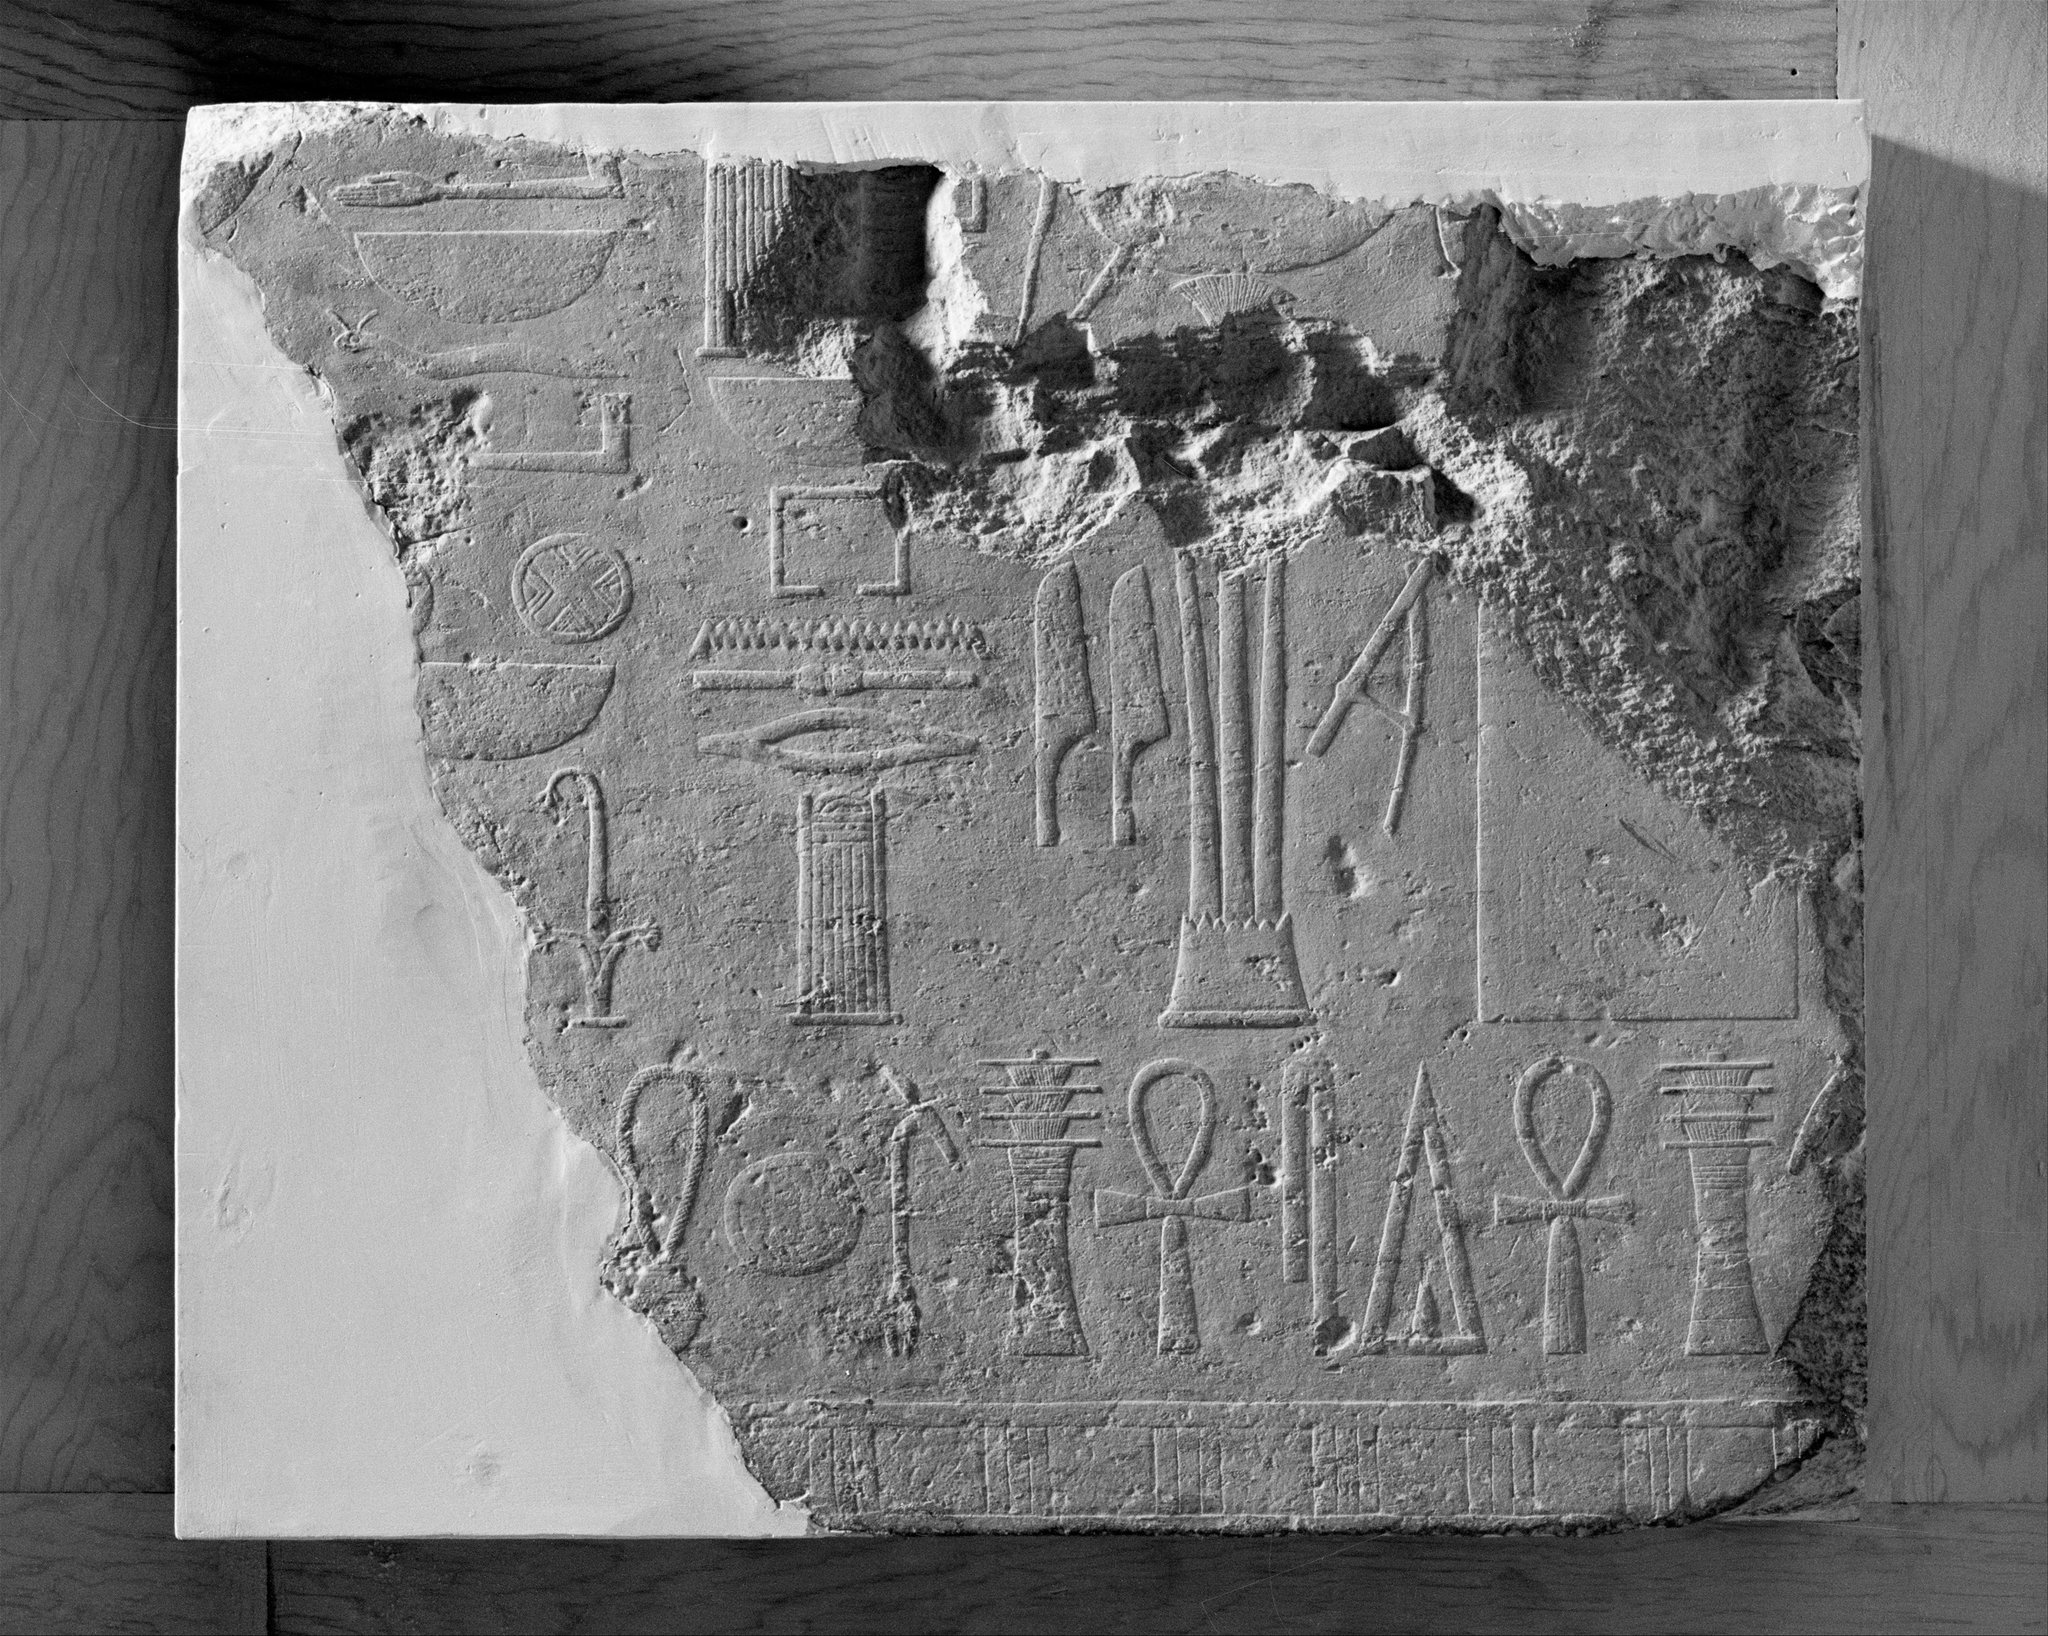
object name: relief, amenemhat i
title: Relief fragment from the mortuary temple of Amenemhat I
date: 1981-1952 BCE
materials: limestone, paint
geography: egypt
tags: hieroglyphs